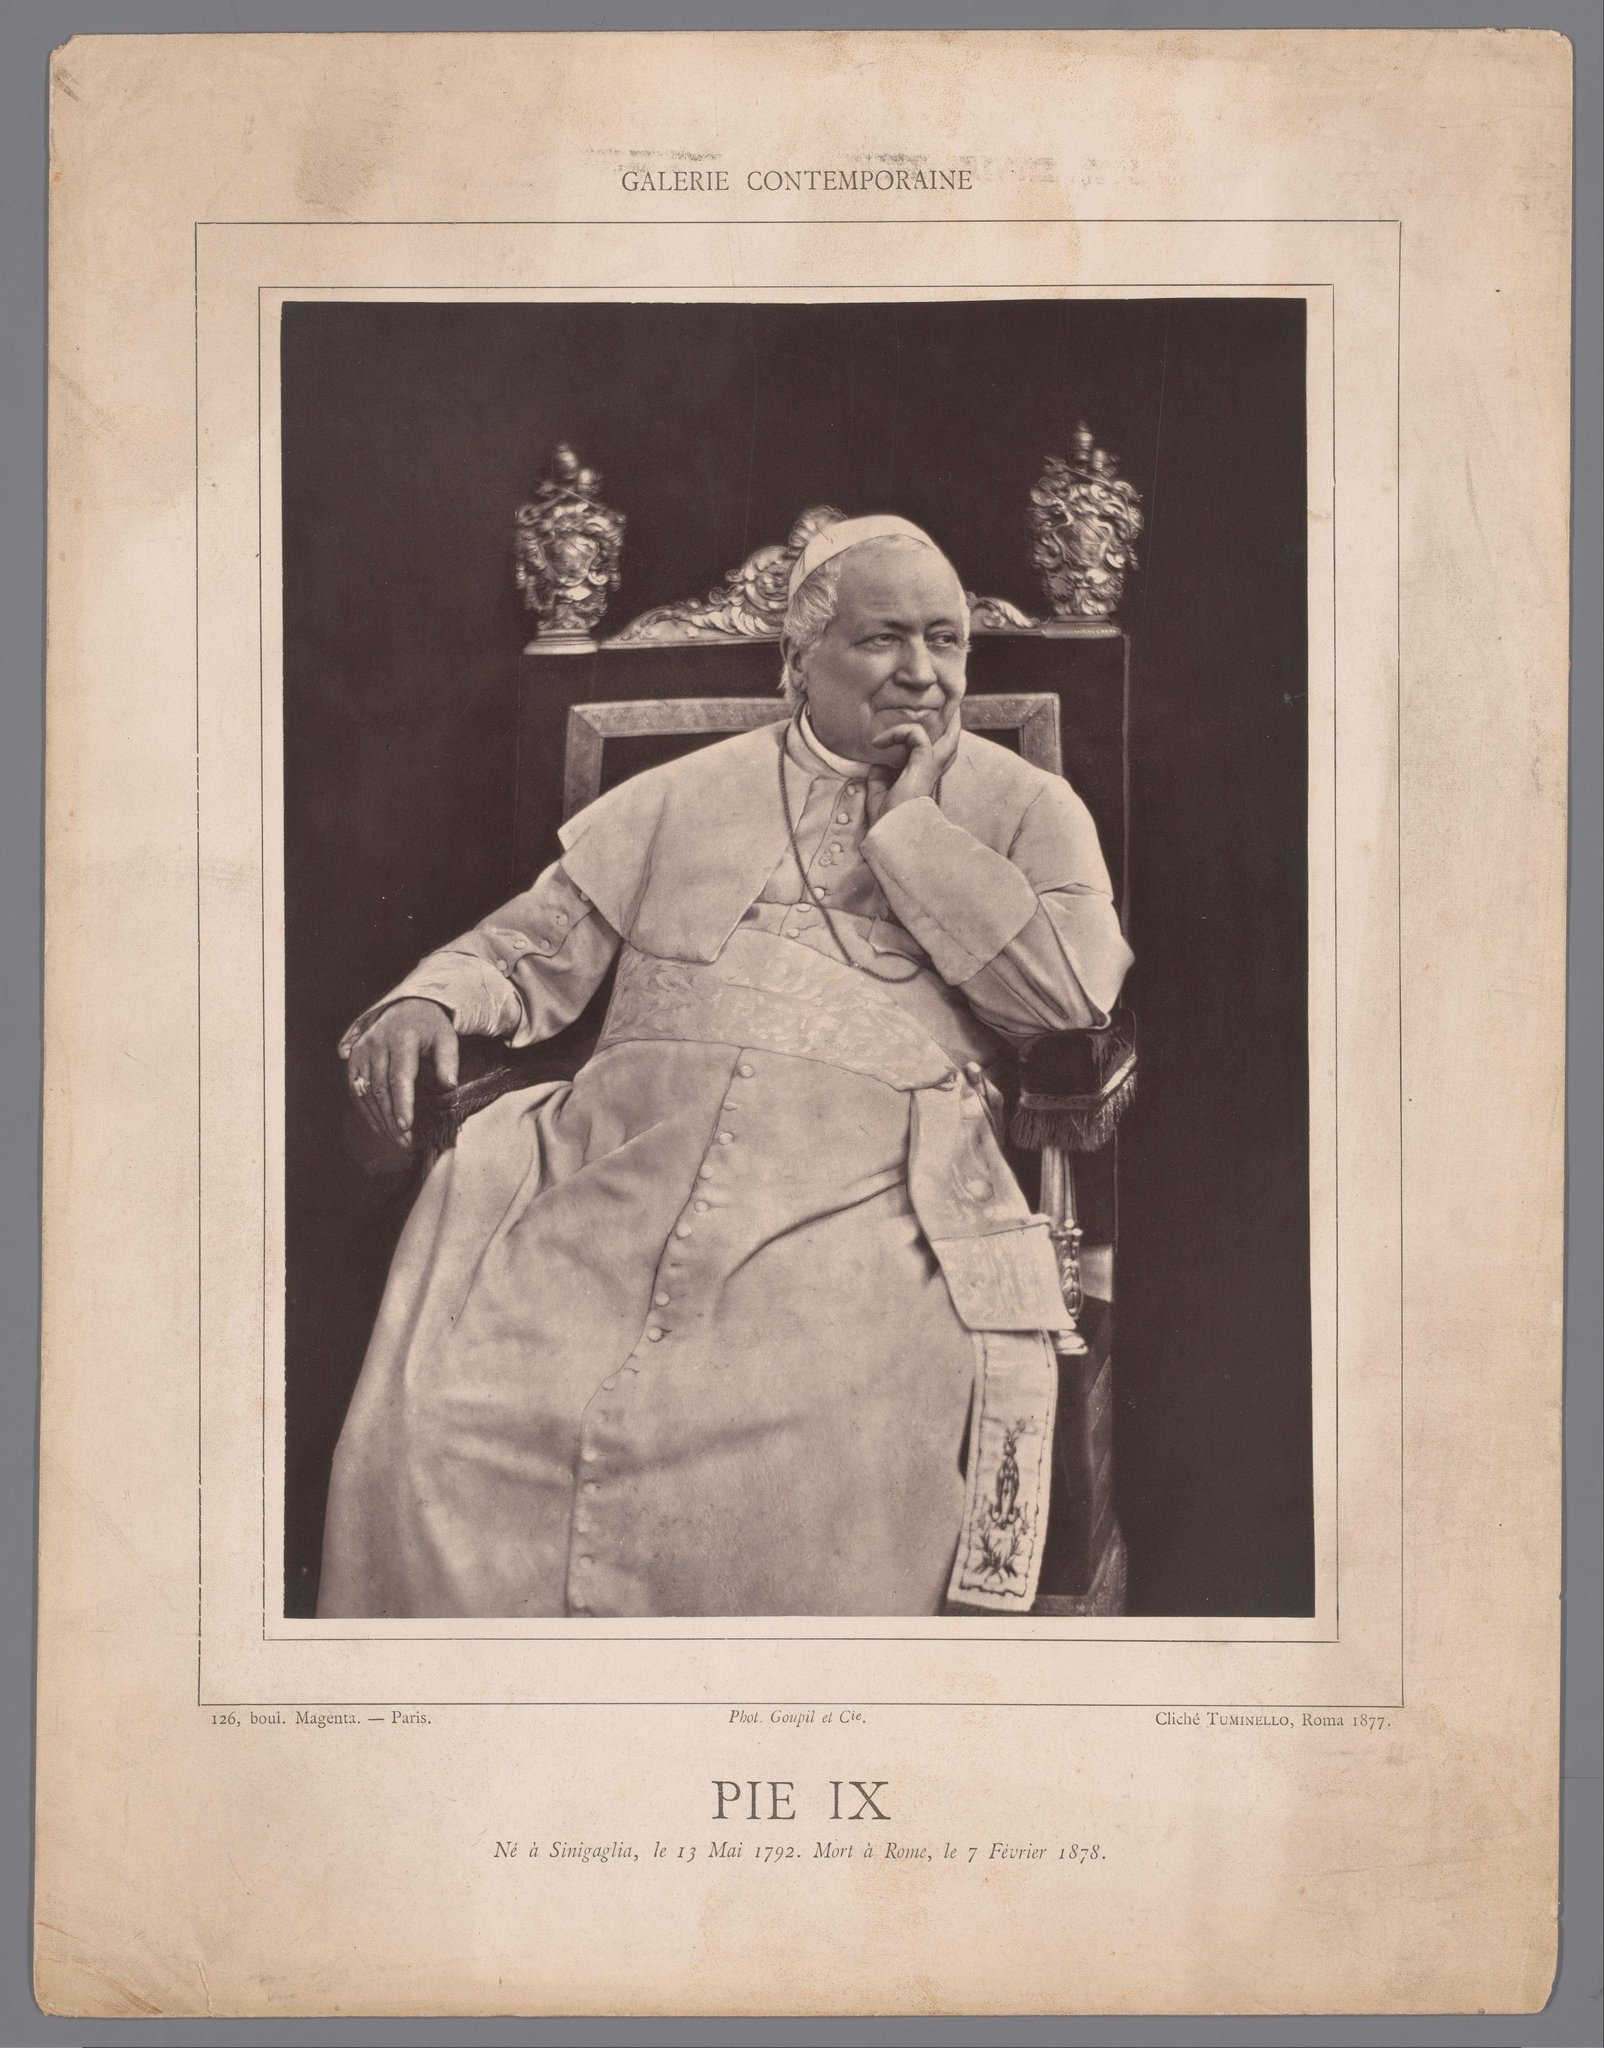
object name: photograph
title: Portret van paus Pius IX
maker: ludovico tuminello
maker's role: fotograaf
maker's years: 1824-1907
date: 1877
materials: cardboard, photographic support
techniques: woodburytype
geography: rome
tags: rome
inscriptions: inscription: ‘Tuminello Carbonprint 1870's’, inscription: ‘PIE IX//Né à Sinigaglia [sic], le 13 Mai 1792. Mort à Rome, le 7 Février 1878.’, inscription: ‘126, boul. Magenta. - Paris Phot. Goupil et Ce. Cliché TUMINELLO, Roma 1877.’, inscription: ‘GALERIE CONTEMPORAINE’, number: ‘1311’